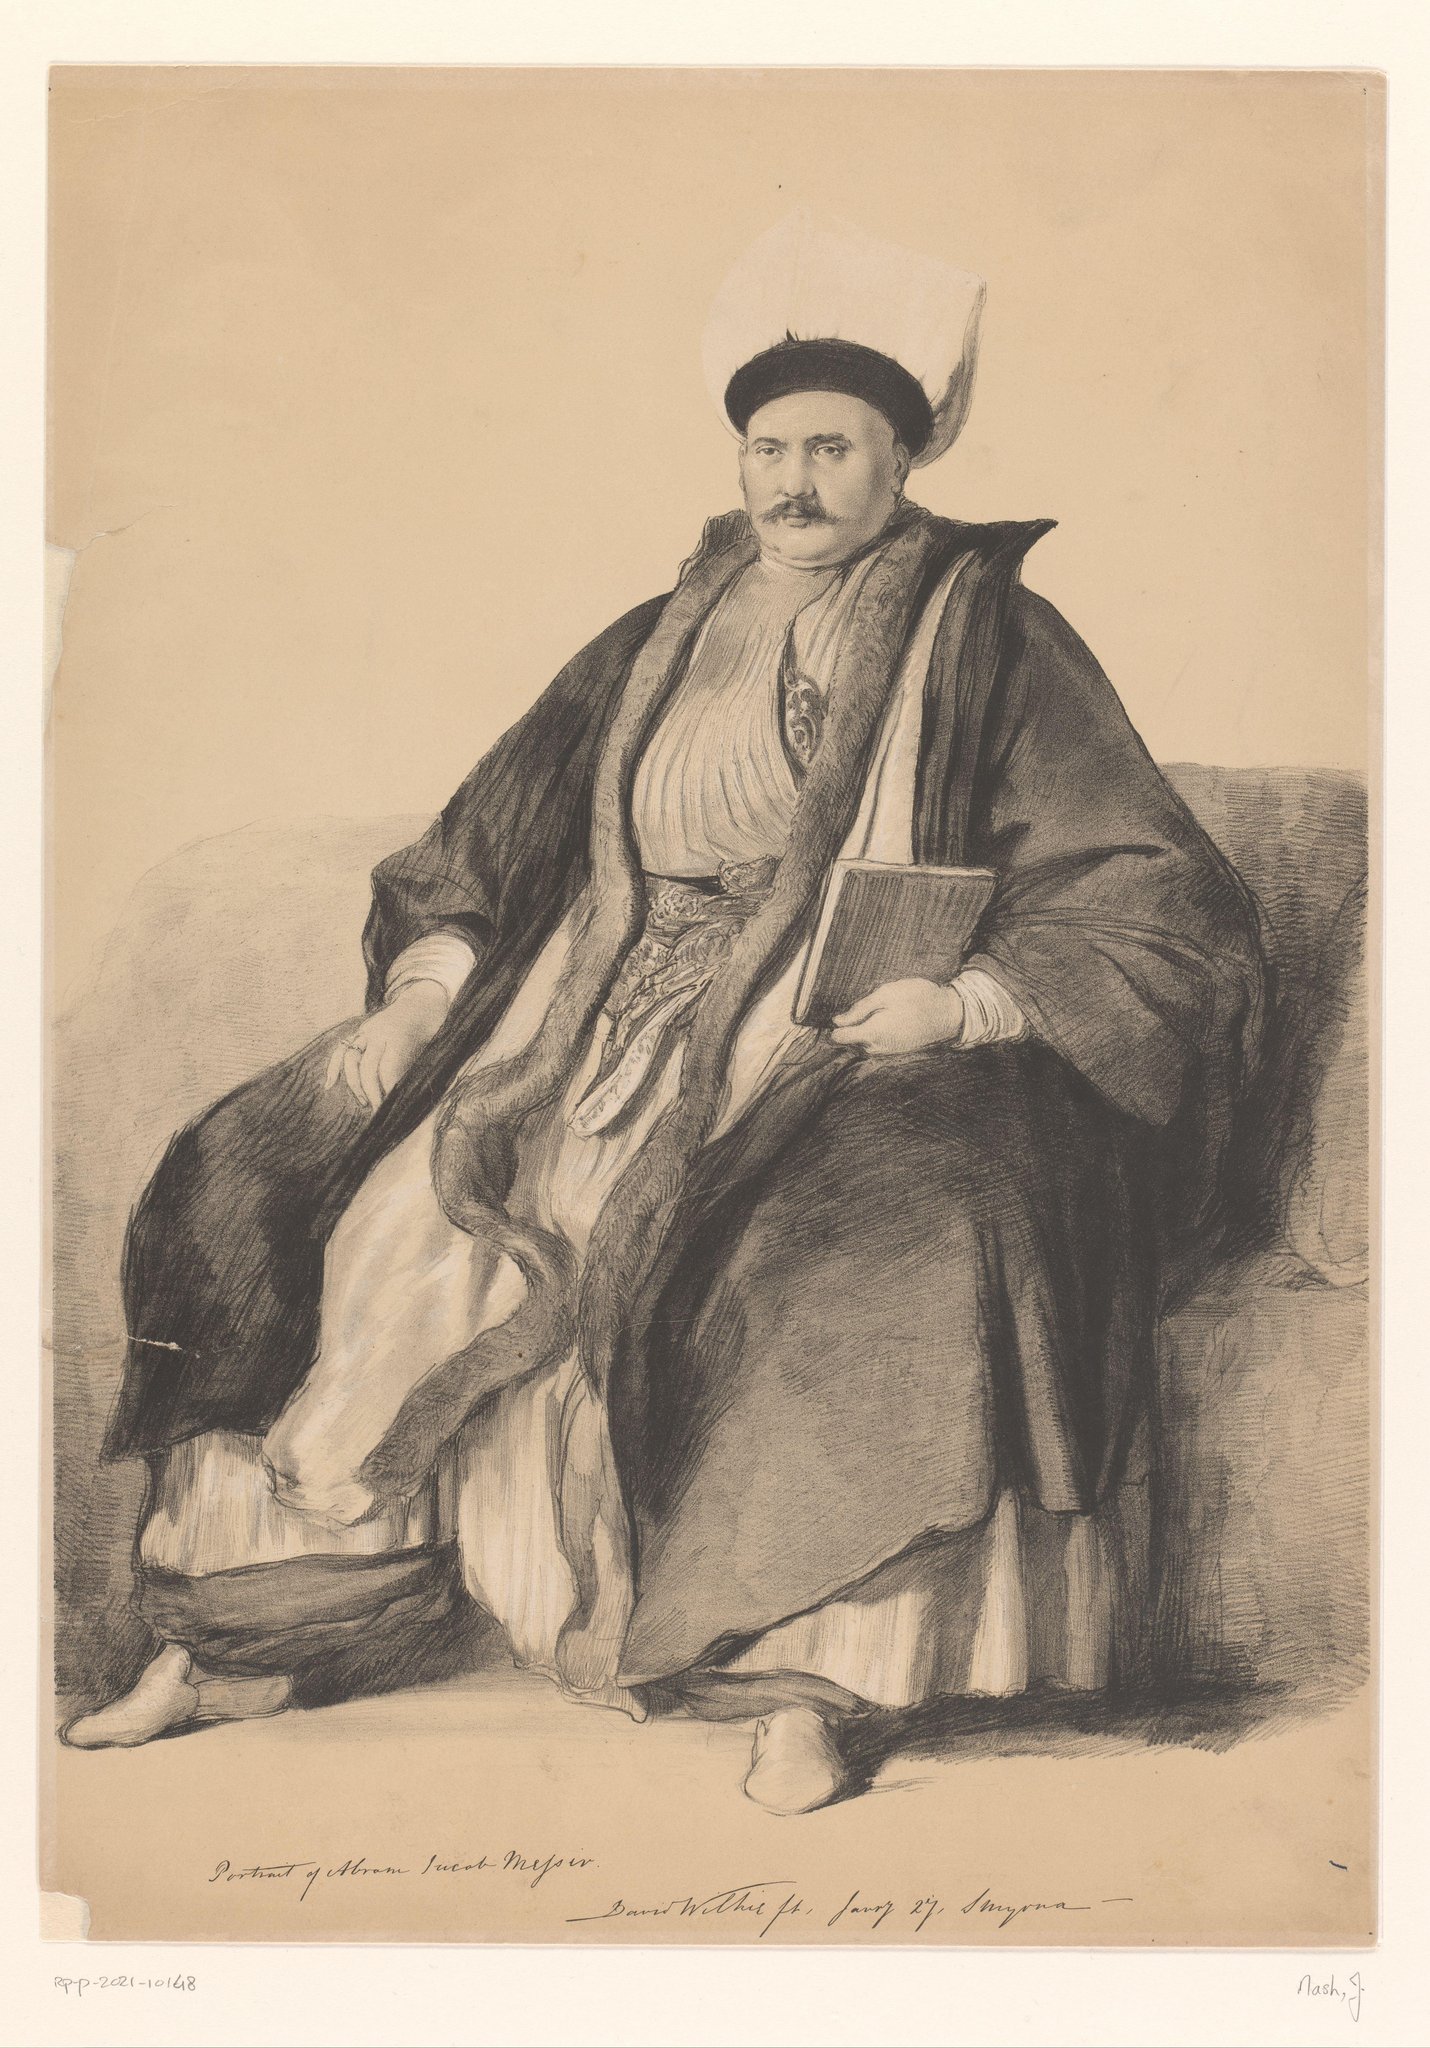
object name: print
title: Portret van Abram Jacob Messir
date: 1843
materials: paint, paper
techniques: brush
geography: london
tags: historical persons